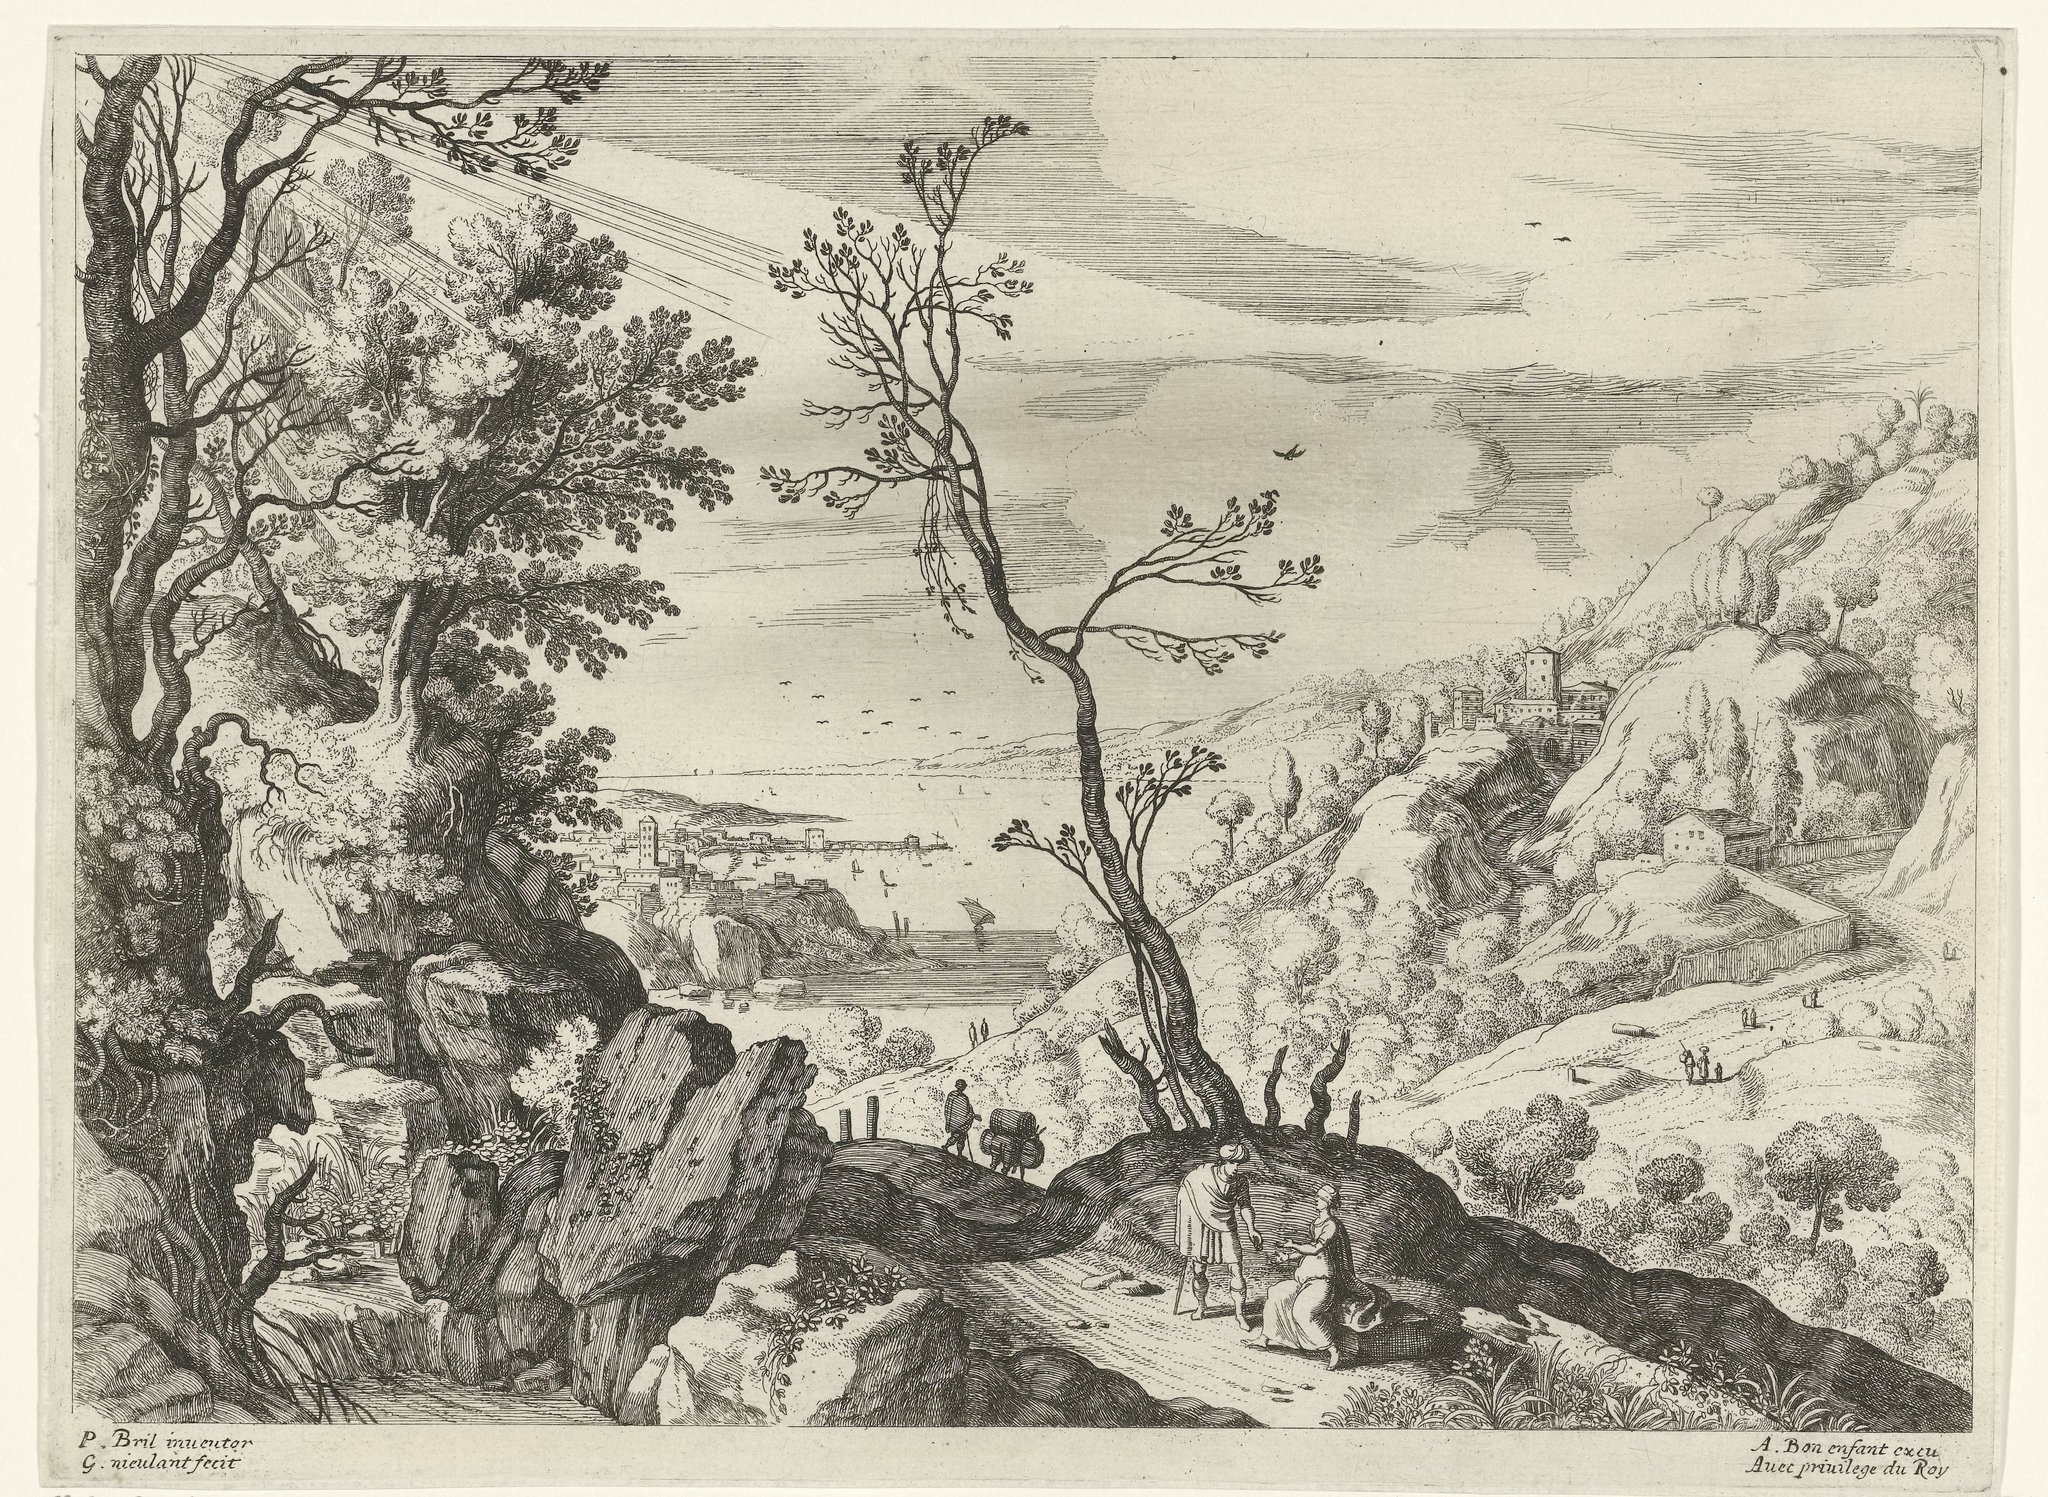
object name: print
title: Landschap met Juda en Tamar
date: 1594-1635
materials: paper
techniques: engraving, etching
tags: landscapes in the temperate zone - hh - ideal landscapes, judah's love-affair with tamar; he gives her his signet(-ring), bracelets and staff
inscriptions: collector's mark: Lugt 240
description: Aan een weg in een heuvelachtig landschap zit de gesluierde Tamar, die de zegel en armbanden van haar schoonvader Juda in ontvangst neemt. Juda herkent haar niet en denkt dat zij een prostituee is. Tamar raakt zwanger en kan door middel van de sieraden, die Juda haar heeft gegeven, bewijzen dat hij de vader van haar kind is. Naar het Bijbelverhaal uit Gen. 38: 1-26. Prent uit een serie Italiaanse landschappen.